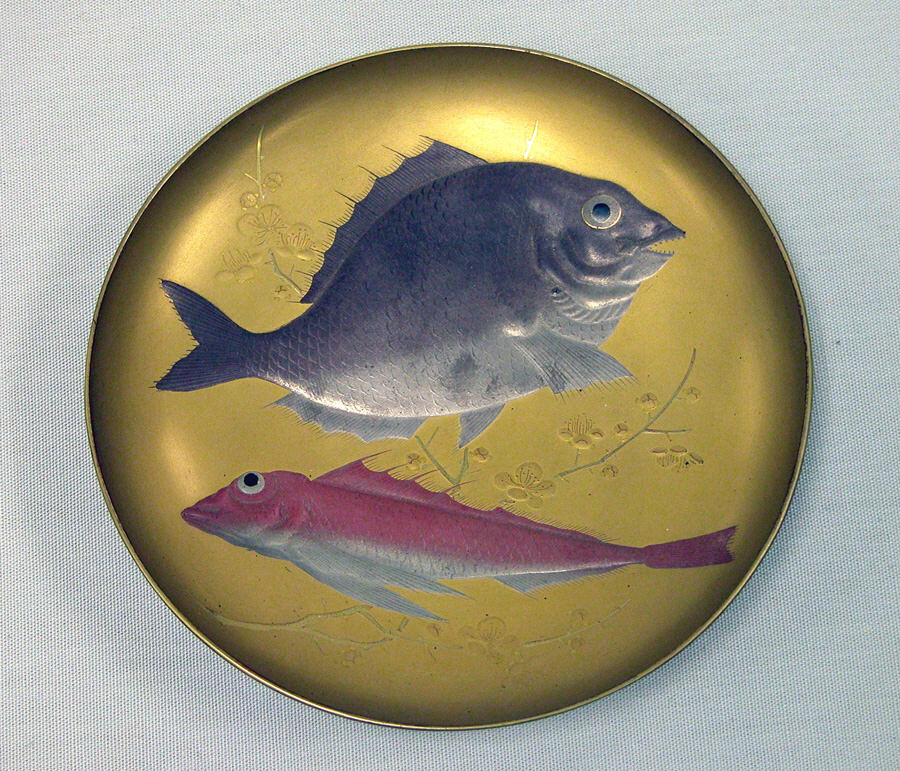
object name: wine cup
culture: japanese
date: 1801-1900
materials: gold, lacquer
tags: fish